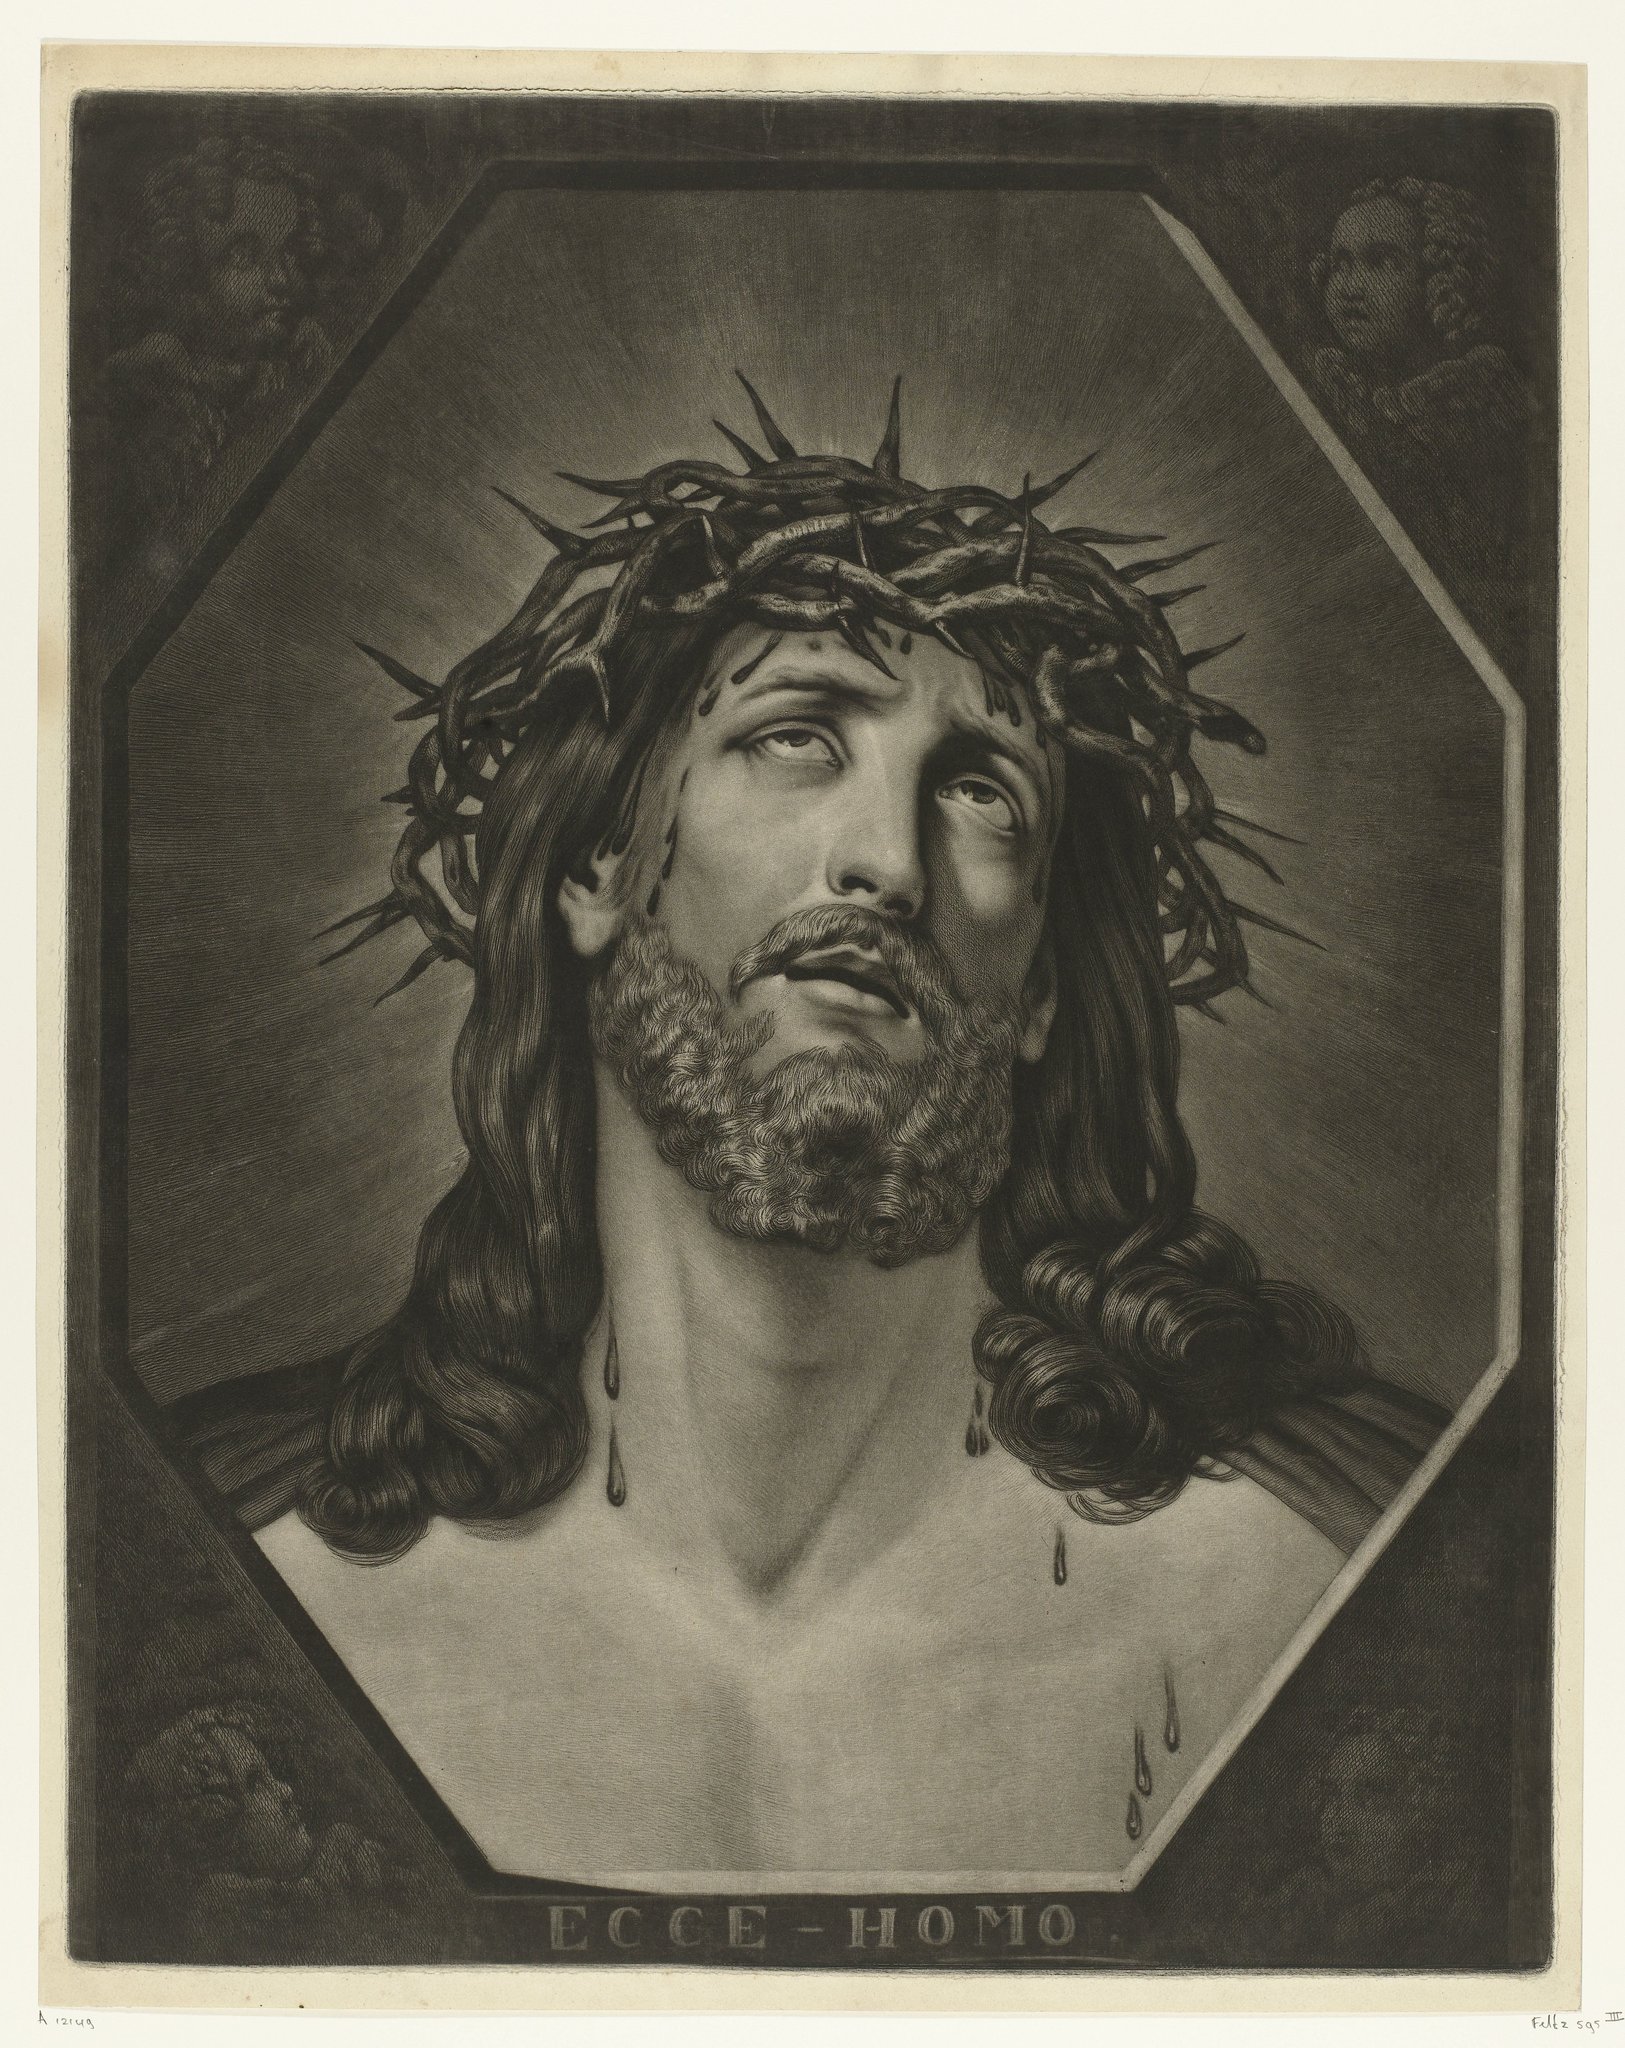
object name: print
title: Ecce homo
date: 1806-1837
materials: paper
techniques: etching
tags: christ alone (also called 'ecce homo')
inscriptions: collector's mark: Lugt 2228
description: Christus met de doornenkroon en een mantel. (Joh. 19.5).